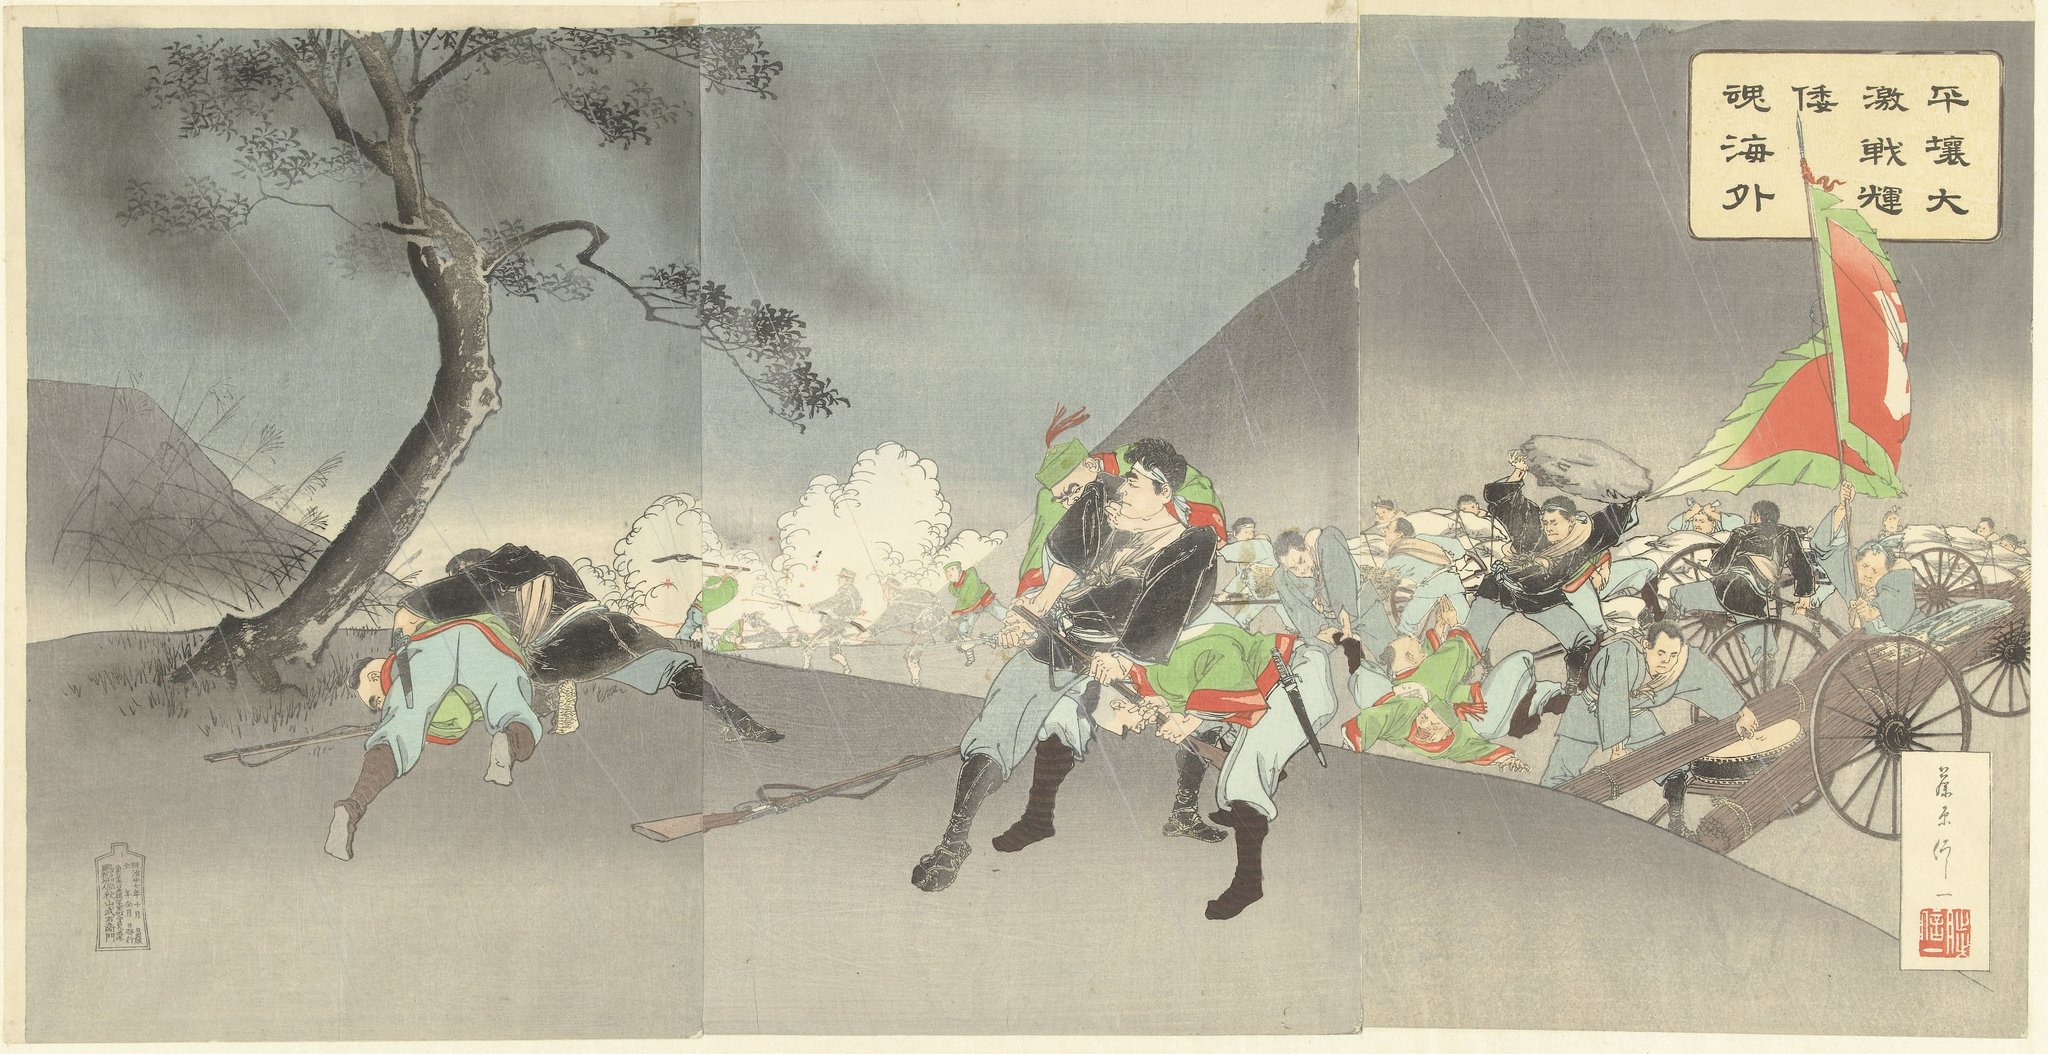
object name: print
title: Heijo daigekisen kiwakon kaigai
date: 1810-1894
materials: paper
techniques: blind stamped, woodcut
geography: japan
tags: war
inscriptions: collector's mark: Lugt 2228, collector's mark: ‘Gebroeders A. Cata, Nijmegen-Amsterdam’, collector's mark: Lugt 2760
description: Berglandschap met gevecht tussen Japanners, in zwart en blauw, en de Chinezen, in groen; tijdens een regenbui.